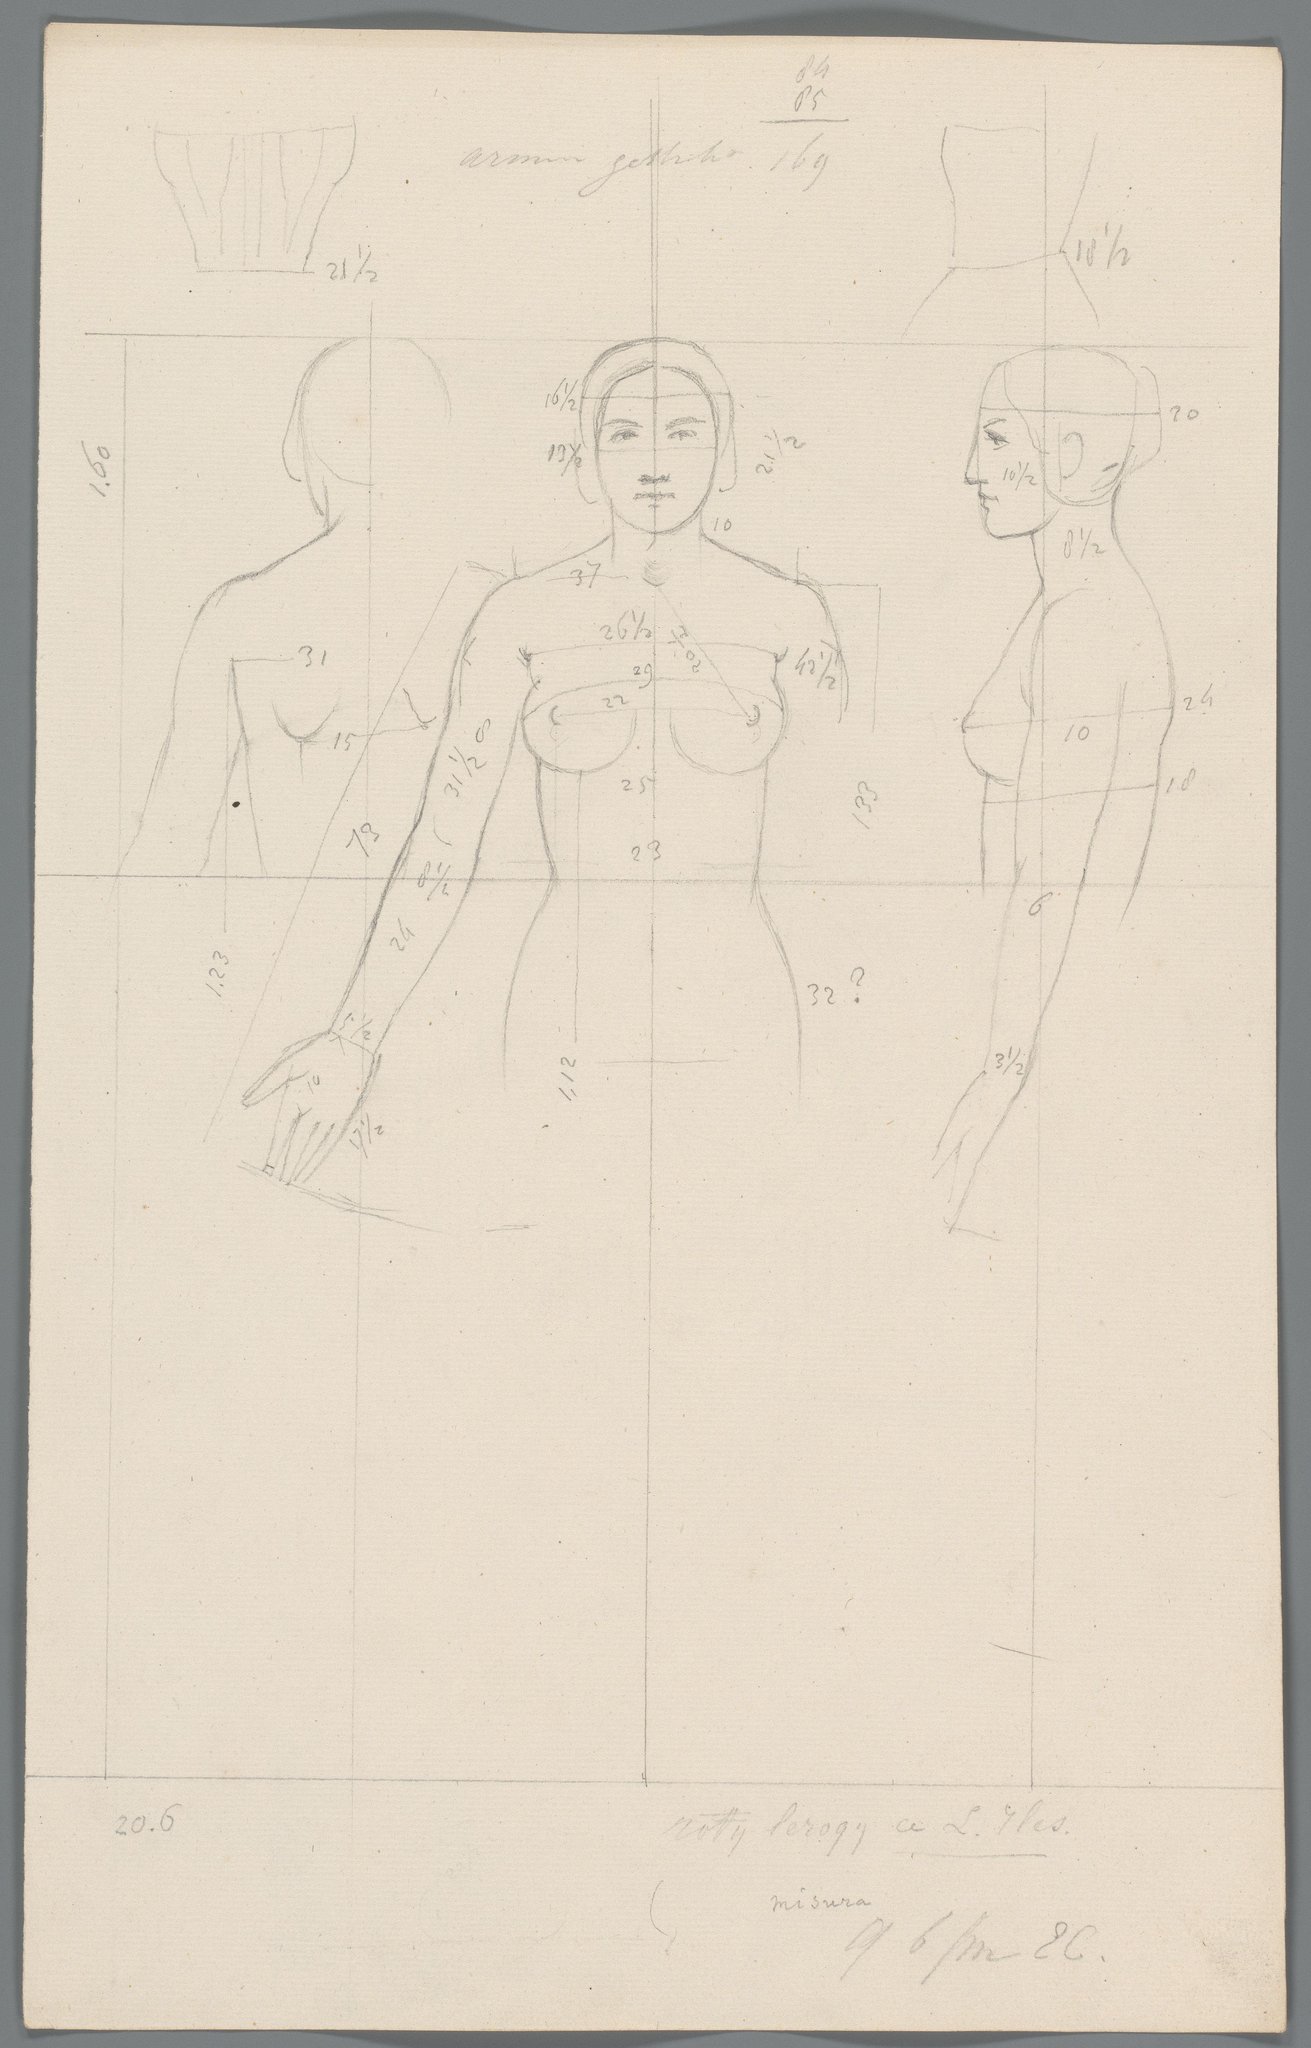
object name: drawing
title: Proportiestudie van het bovenlichaam van een vrouw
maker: jacobus everhardus josephus van den berg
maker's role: draughtsman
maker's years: 1802-1861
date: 1853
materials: paper, pencil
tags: standing figure (canon, proportions) - aa - female human figure, anatomy (non-medical) - aa - female human figure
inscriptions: inscription: ‘[...] misura 6 fm EC’